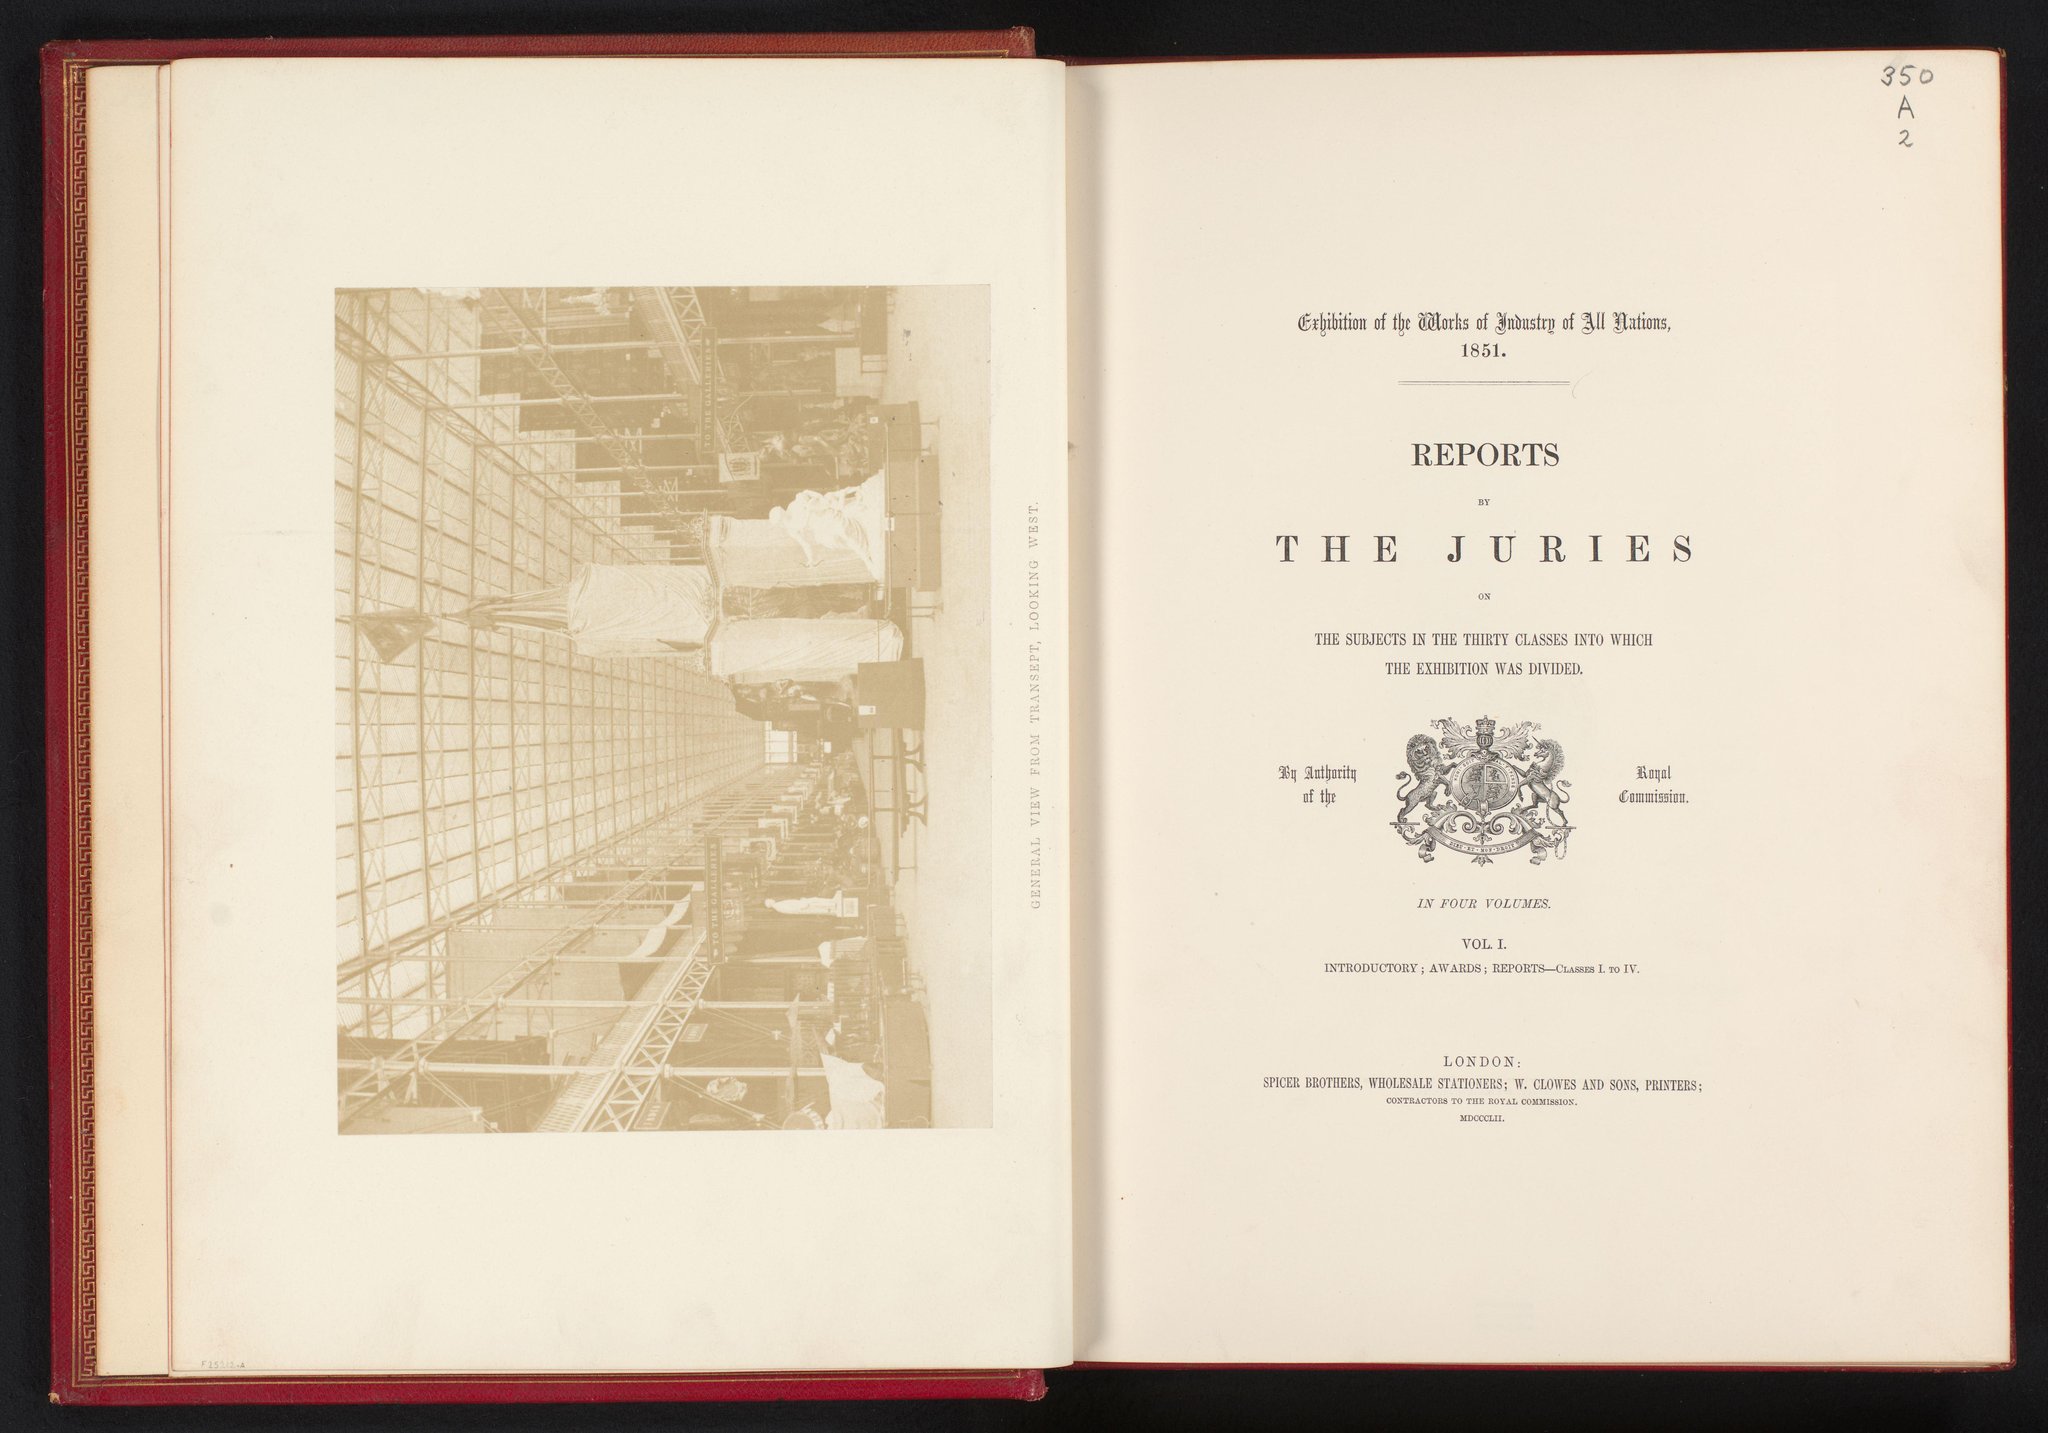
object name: book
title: Exhibition of the works of industry of all nations 1851 : reports by the juries on the subjects in the thirty classes into which the exhibition was divided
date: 1851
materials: leather, paper, photographic support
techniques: salted paper print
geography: london